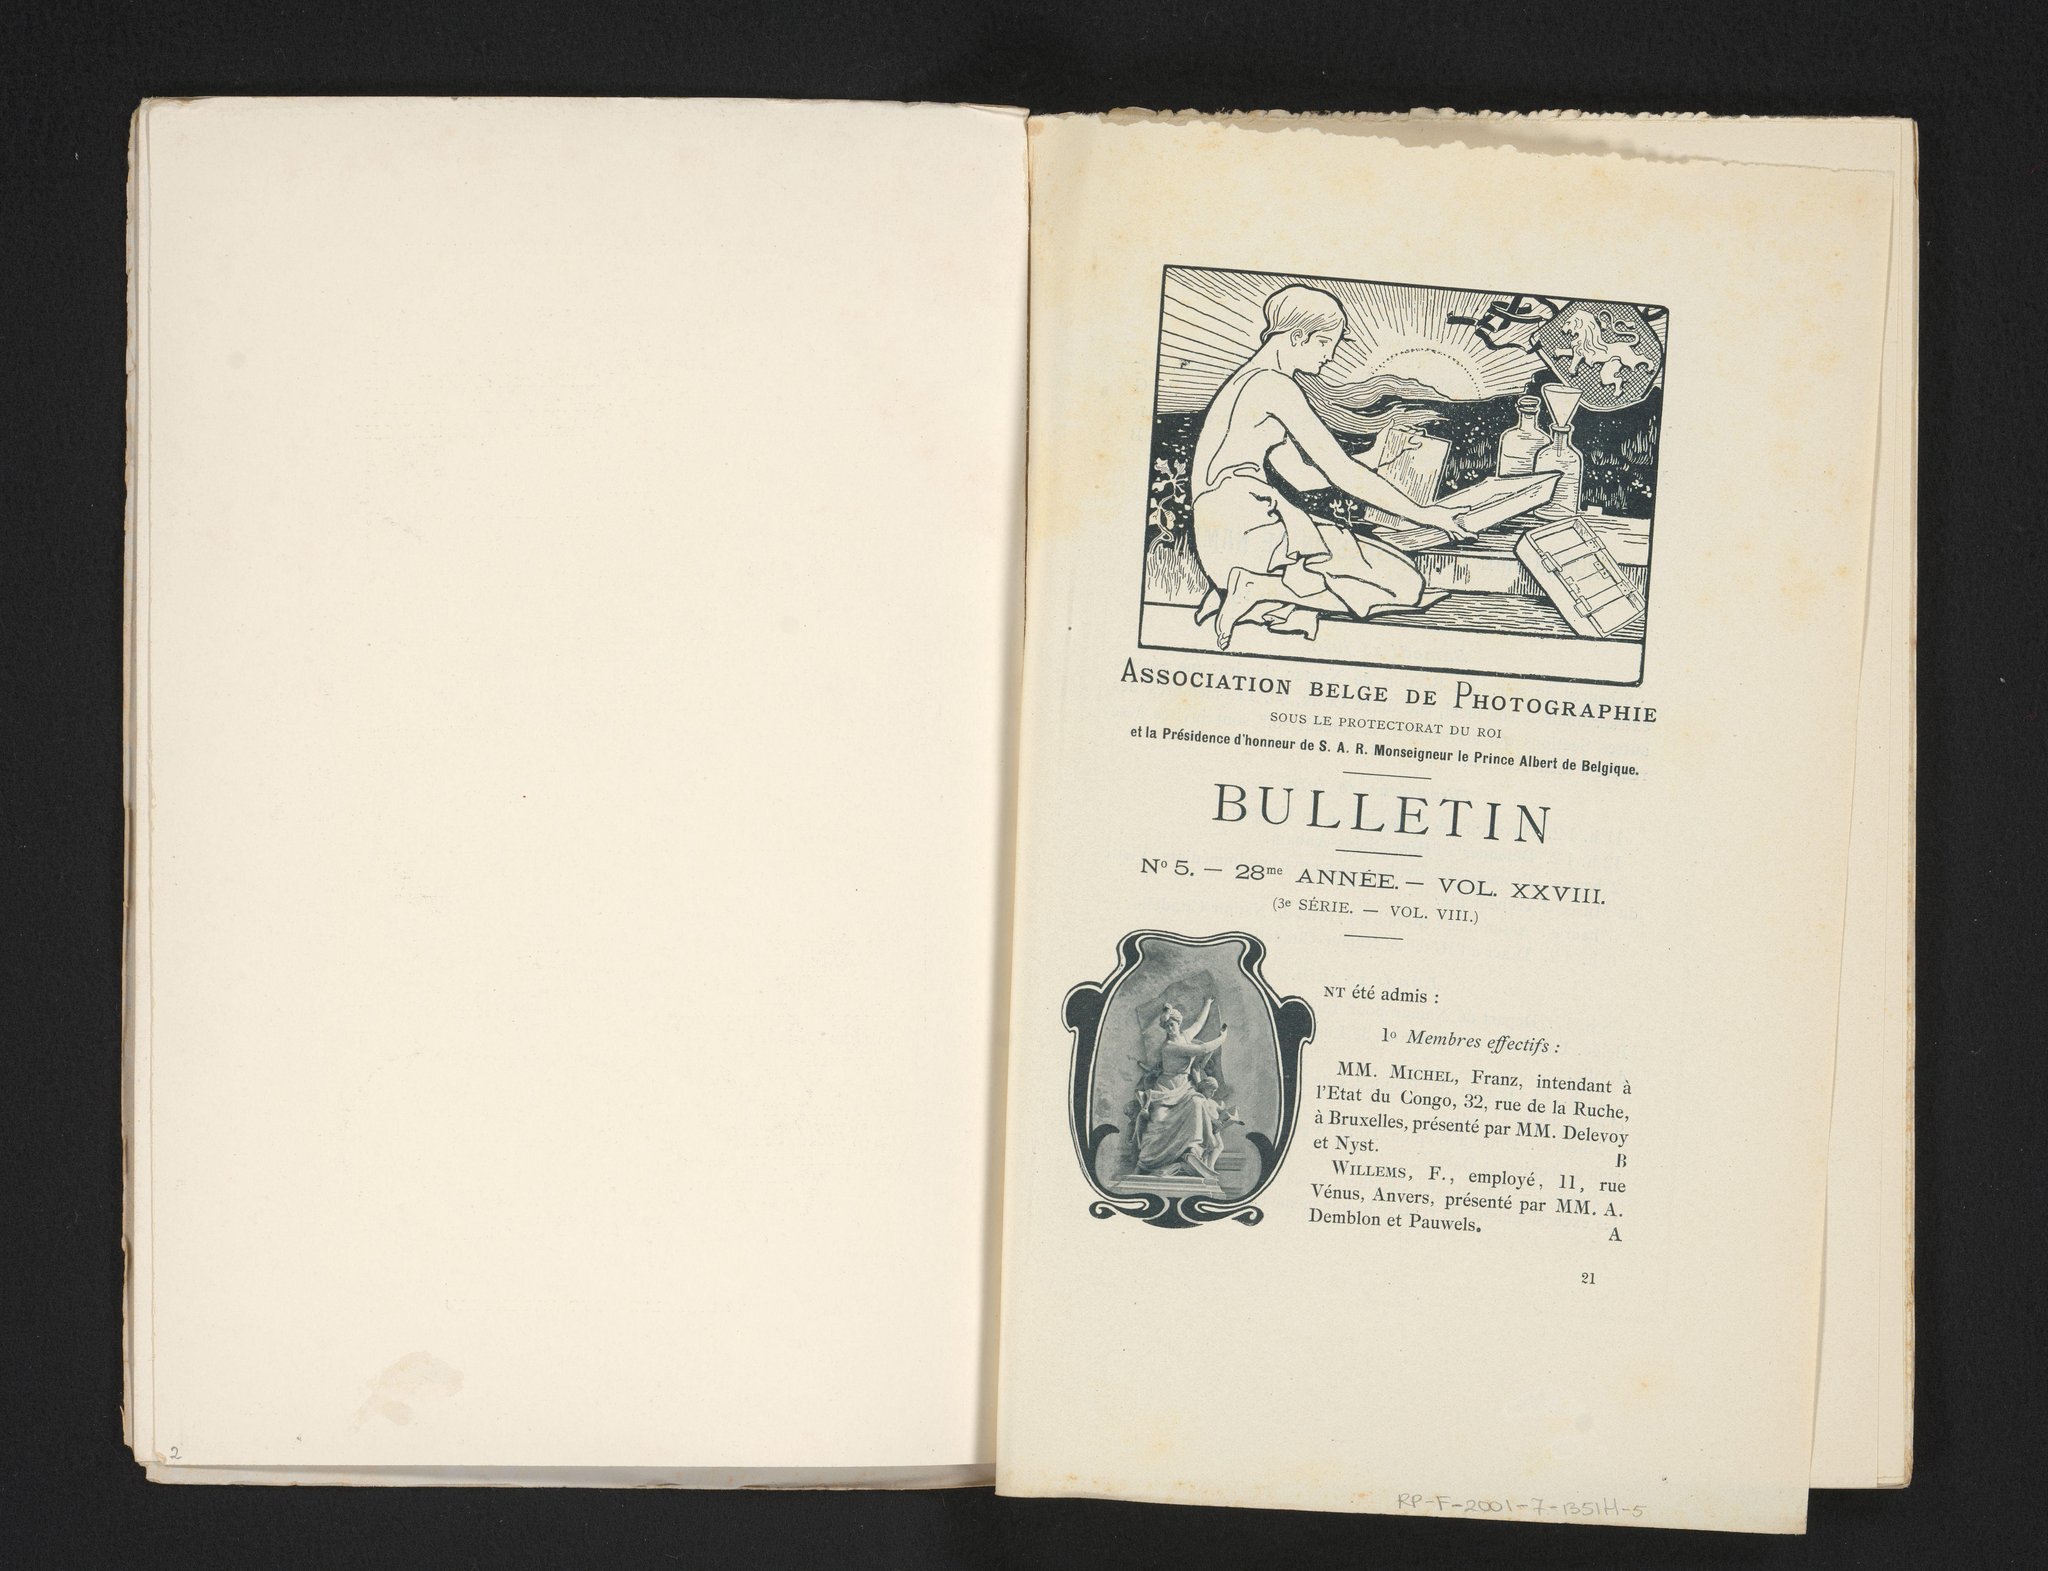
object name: book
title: Bulletin / Association belge de photographie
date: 1901-1905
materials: paper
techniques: printing, engraving